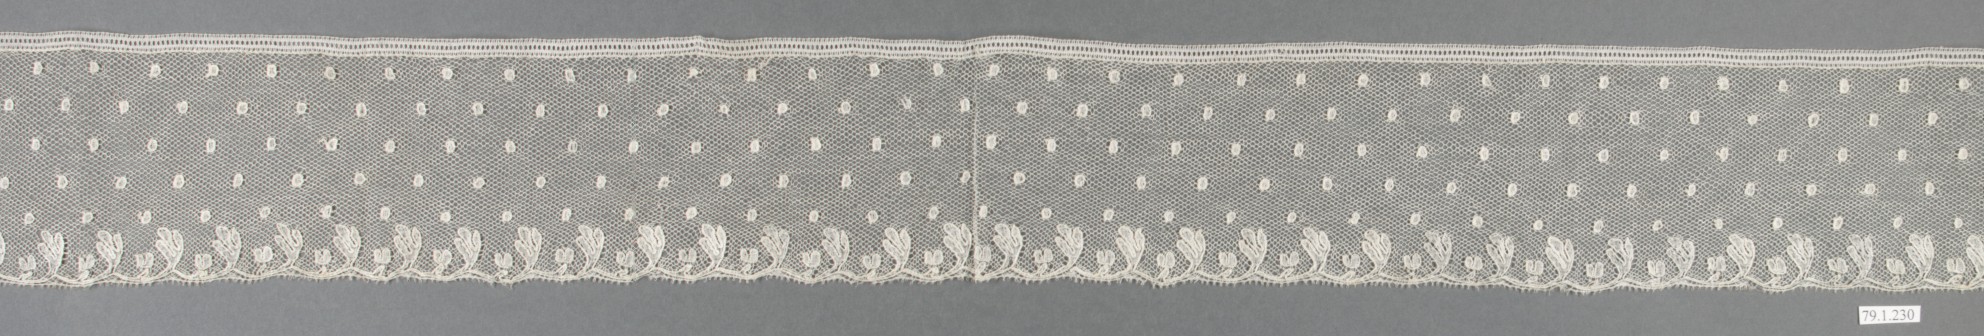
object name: strip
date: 1800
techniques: lace